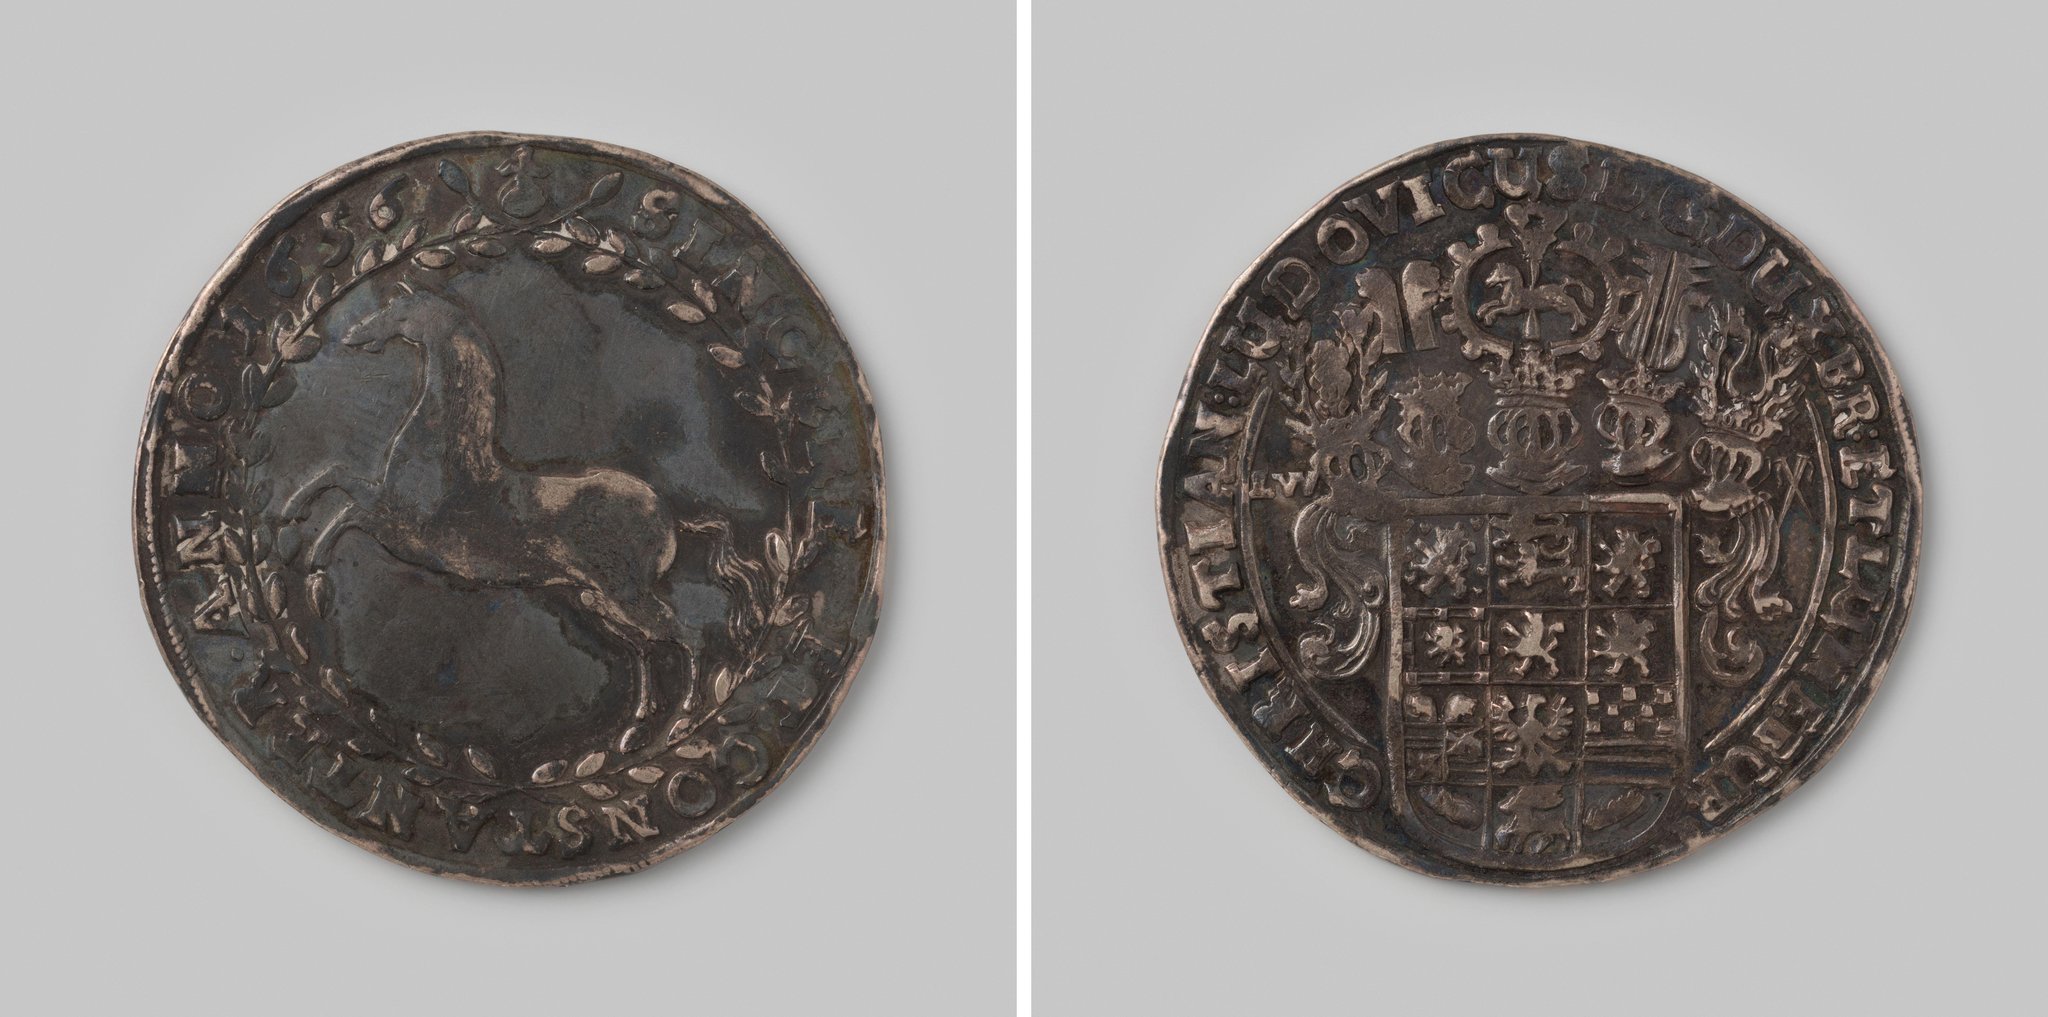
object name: taler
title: Brunswijk, taler, Christian Ludwig, 1656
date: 1656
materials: silver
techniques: striking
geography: goslar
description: Zilveren munt. Voorzijde: samengesteld wapenschild, waarboven vijf helmtekens. Keerzijde: binnen twee gekruiste takken springend paard naar links. Jaartal aan het eind van het omschrift.